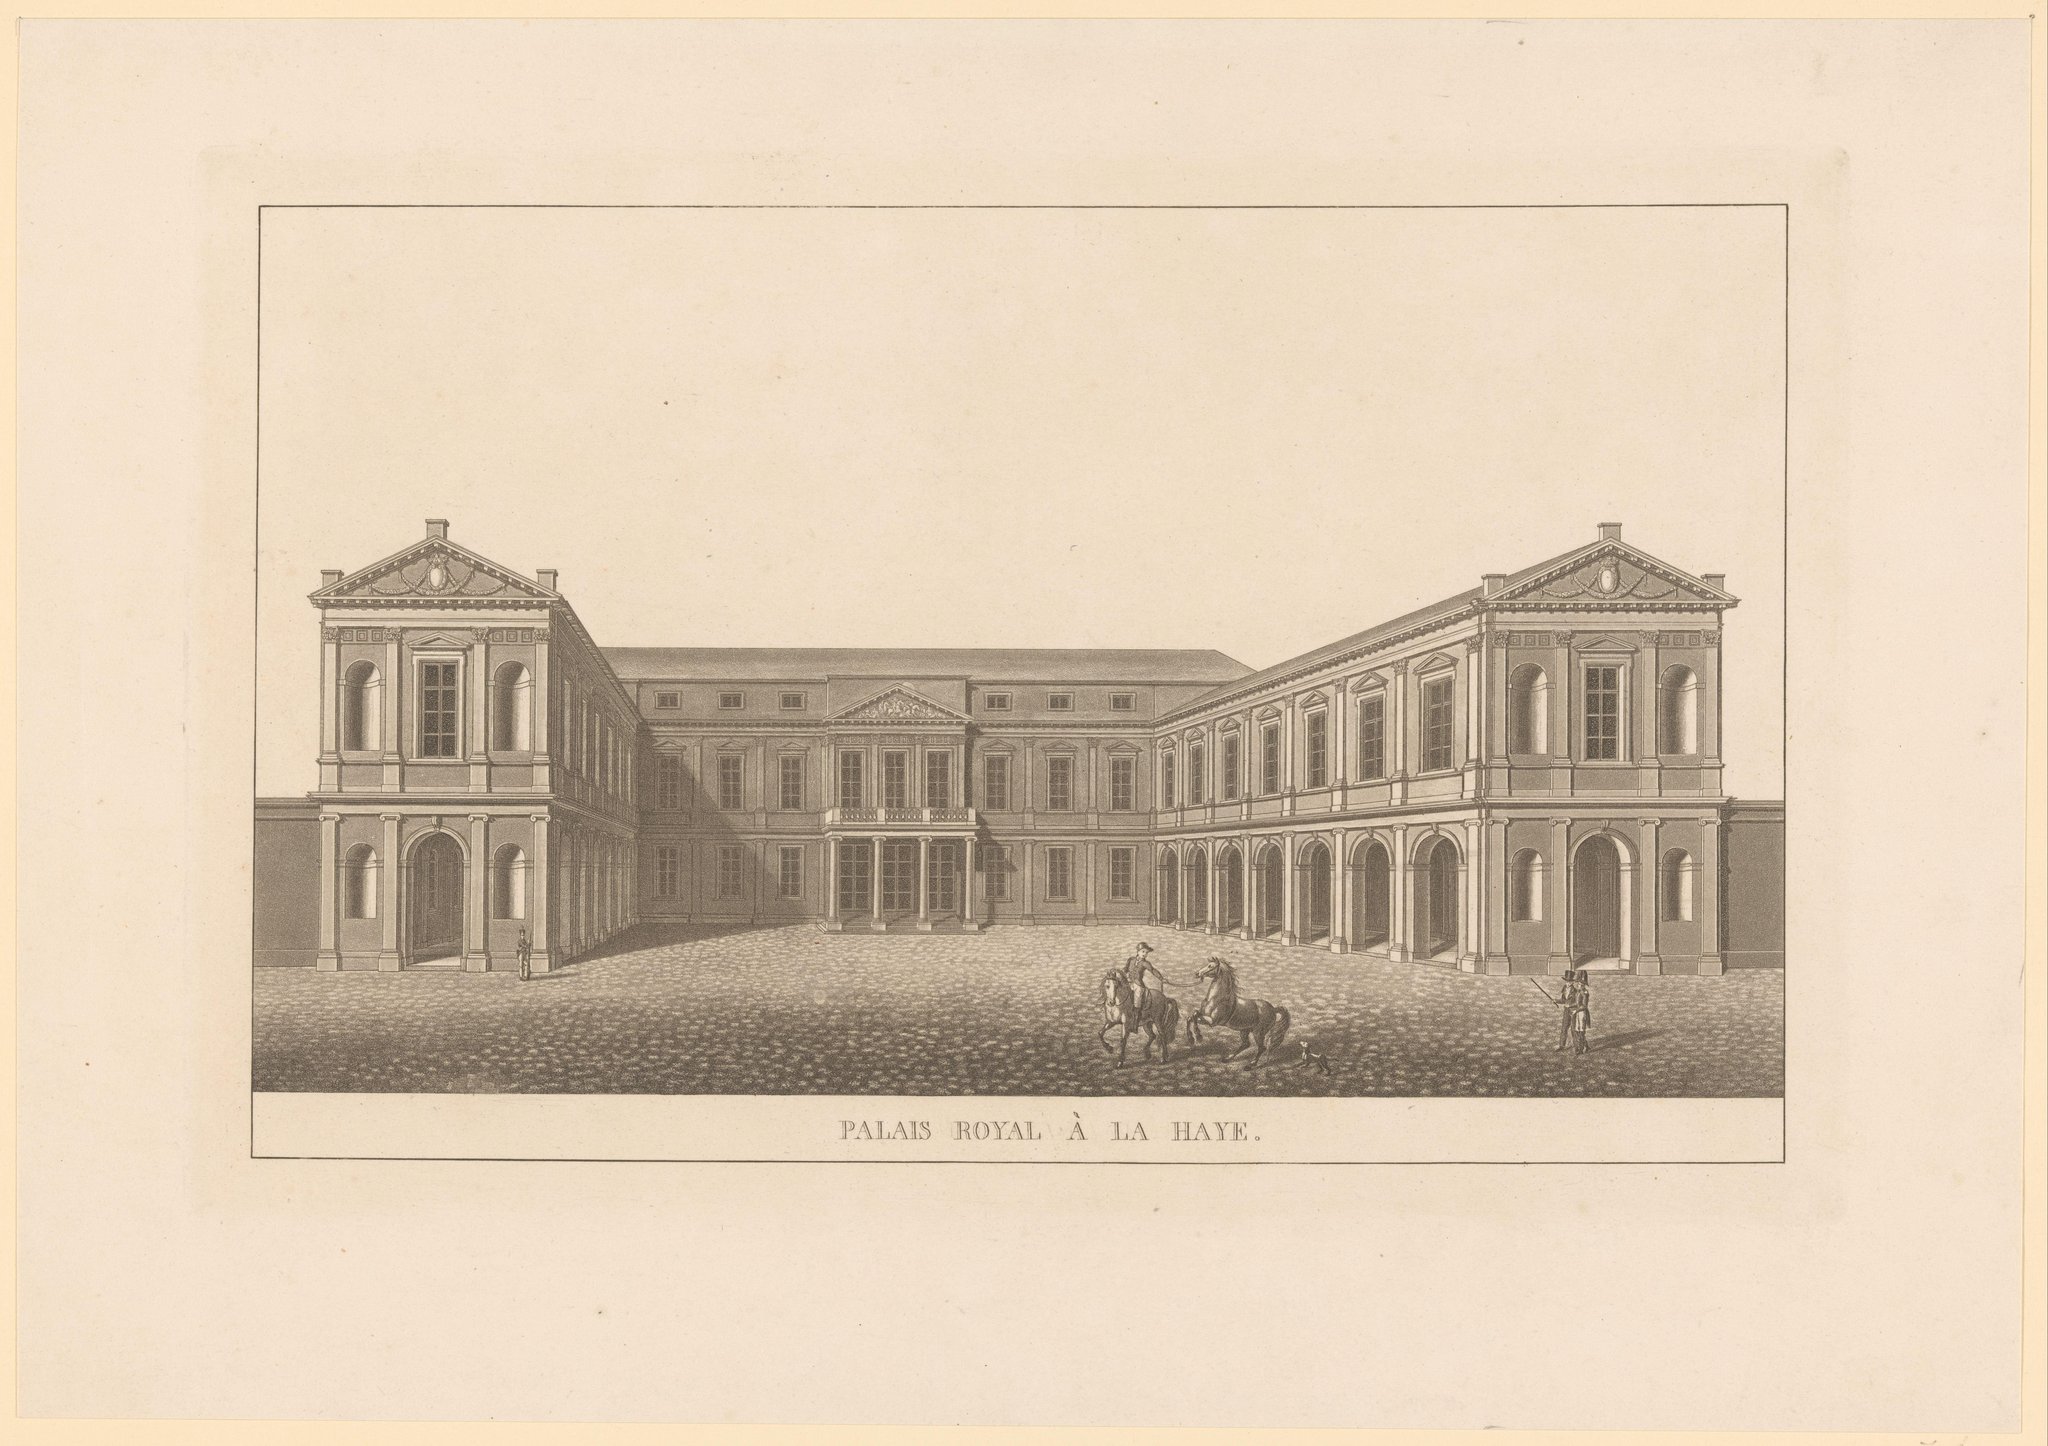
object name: print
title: Paleis Noordeinde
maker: Anonymous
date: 1800-1850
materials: paper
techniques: aquatint, etching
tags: palace